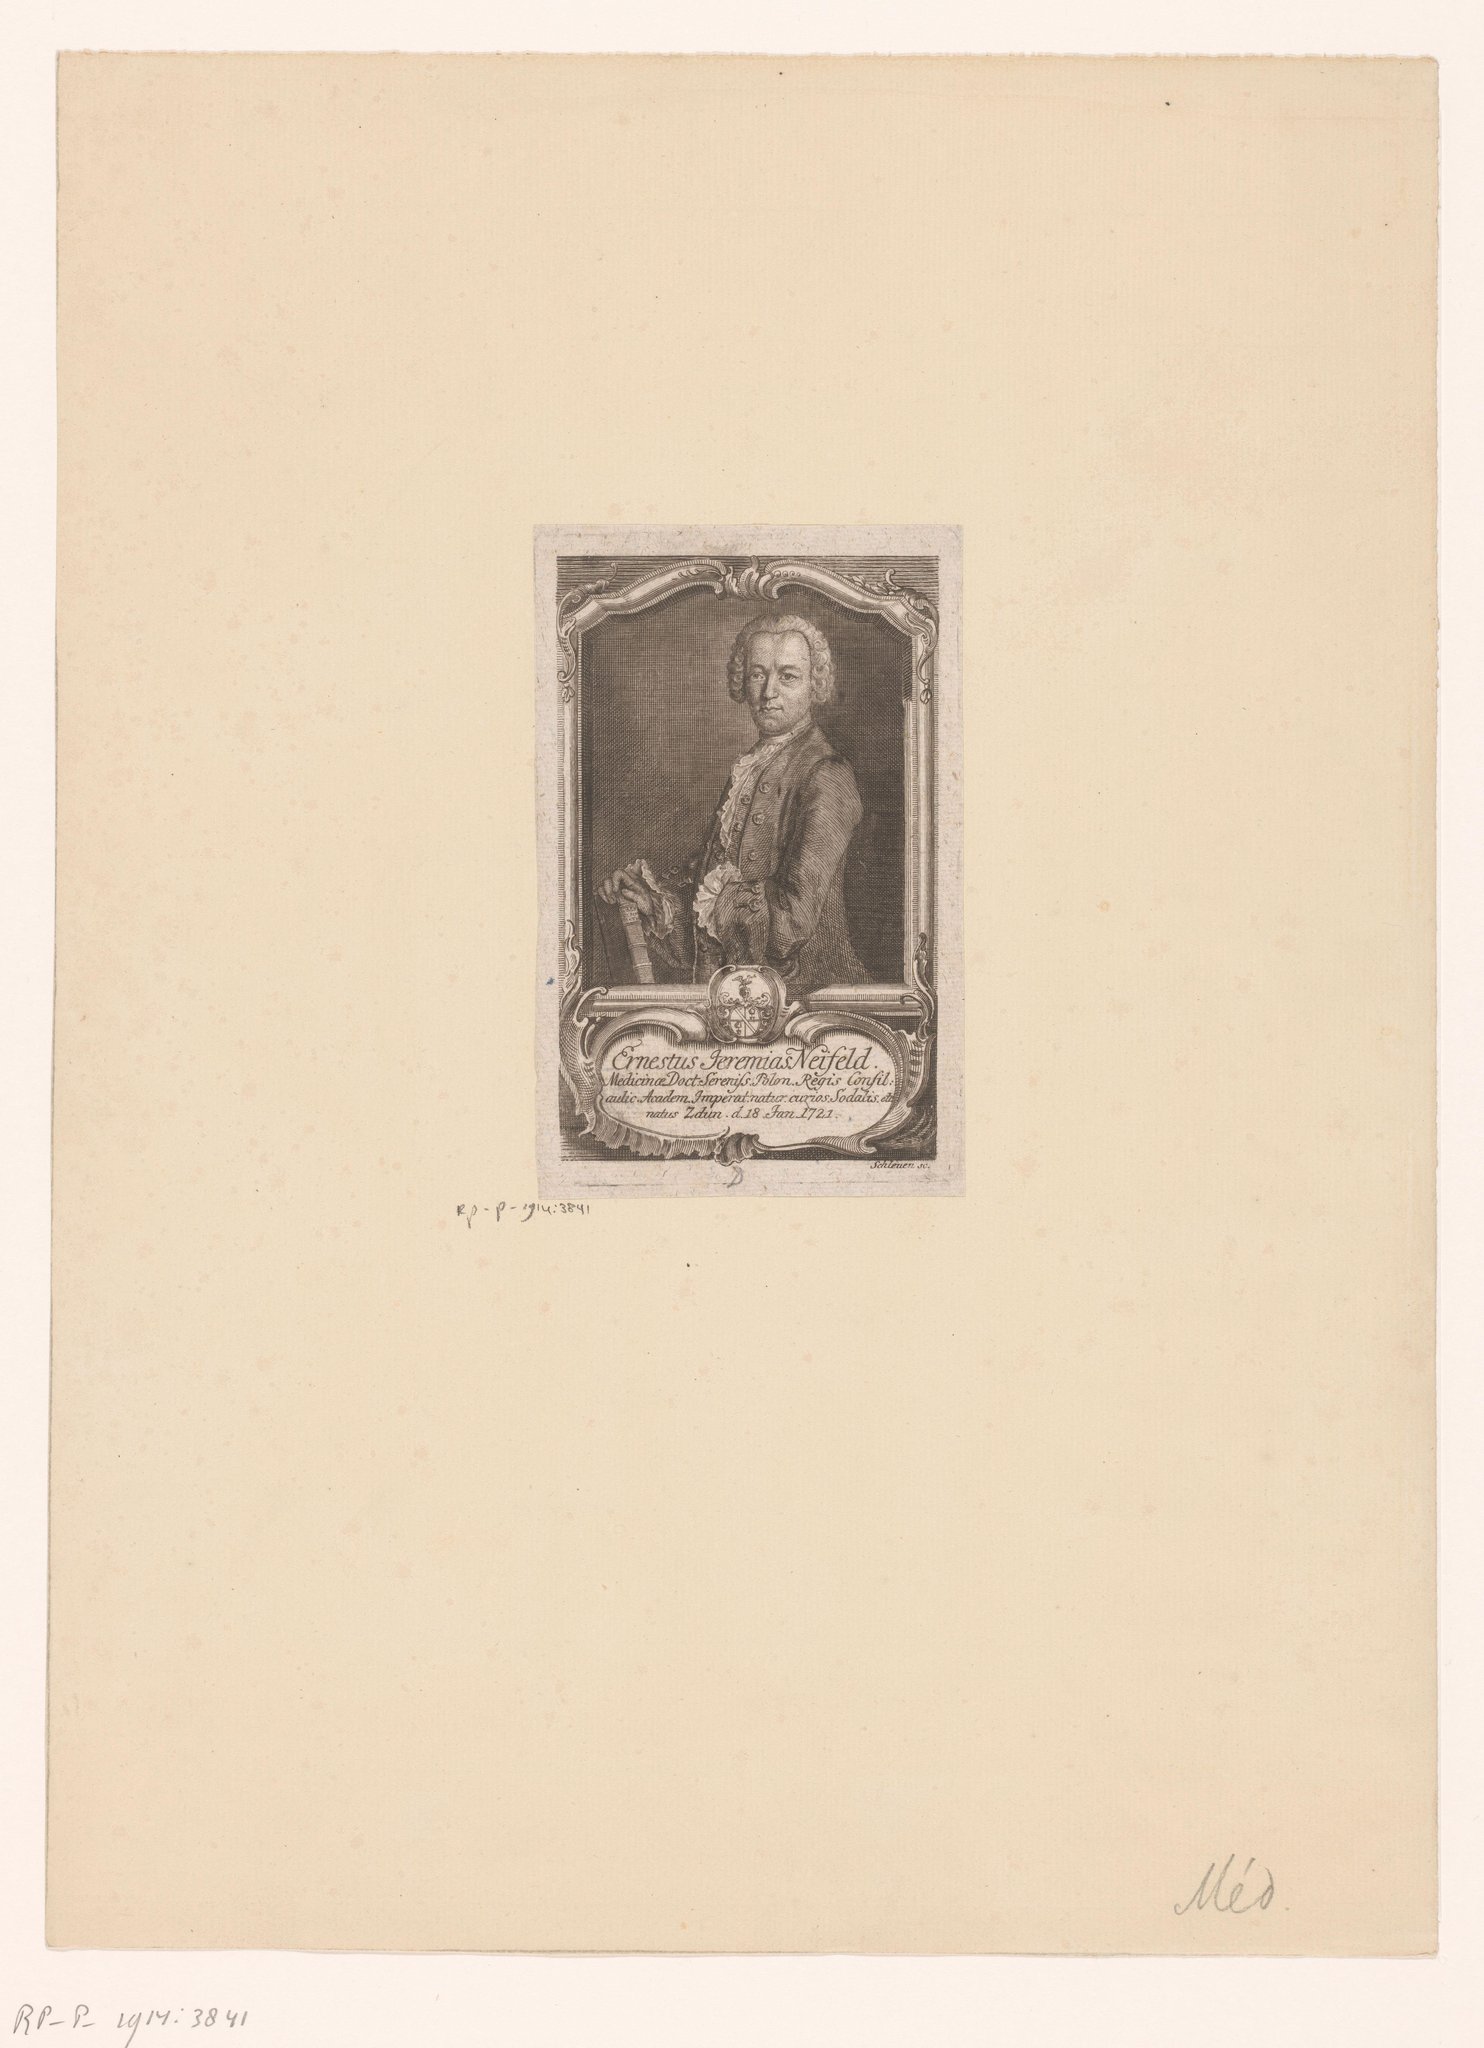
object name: print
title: Portret van Ernst Jeremias Neifeld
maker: johann david schleuen (i)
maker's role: print maker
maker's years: 1711-1774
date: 1721-1771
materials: paper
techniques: engraving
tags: historical persons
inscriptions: collector's mark: Lugt 2228